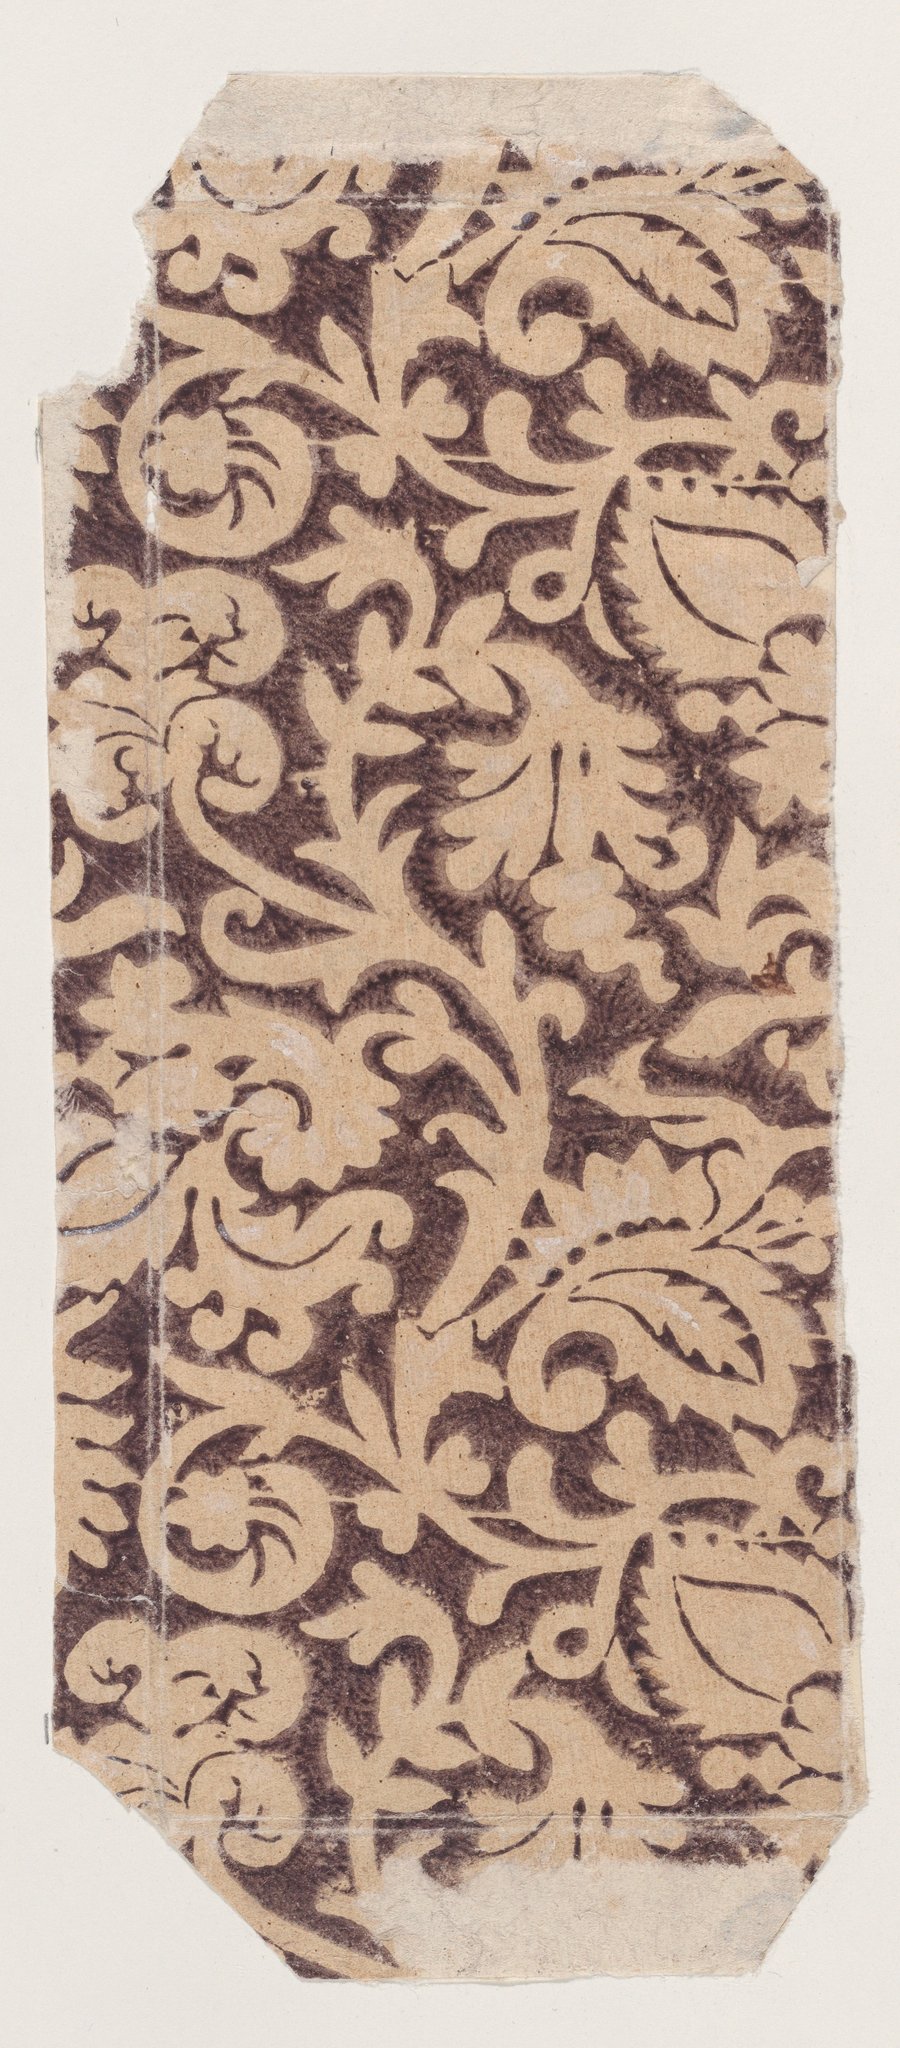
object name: print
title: Sheet with overall leaf and vine pattern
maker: Anonymous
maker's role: artist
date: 1801-1900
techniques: relief print